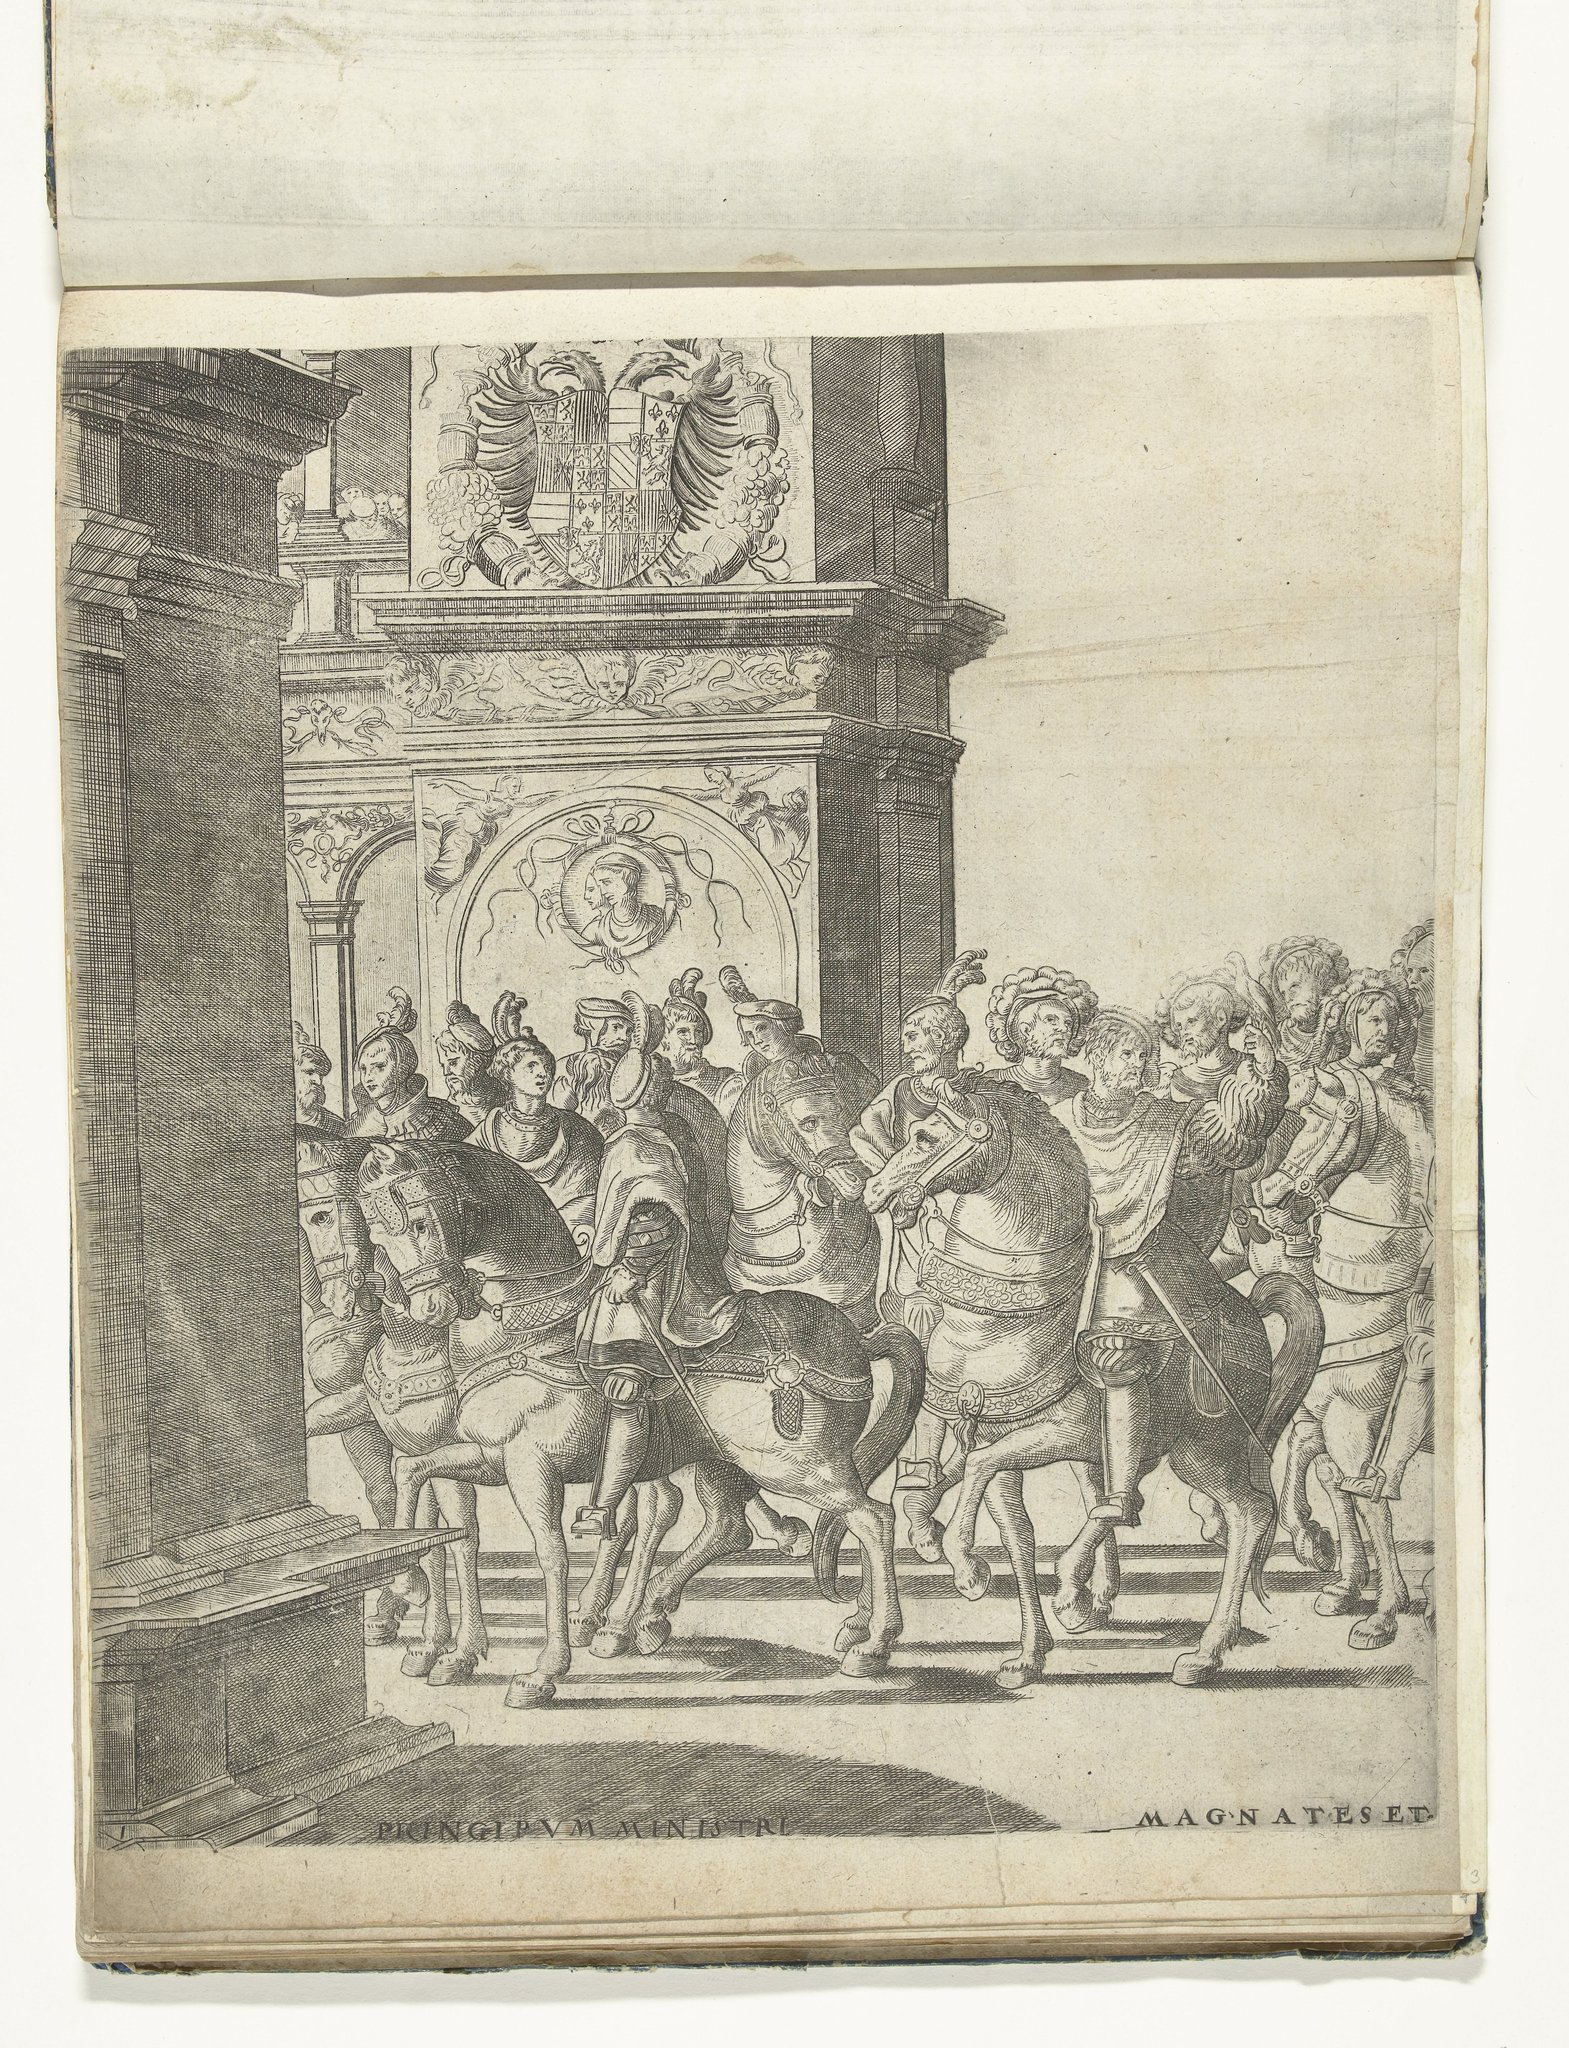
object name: print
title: Optocht van Karel V met de paus te Bologna na zijn kroning to keizer, 1530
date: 1530-1536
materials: paper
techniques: engraving, etching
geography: mechelen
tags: ghent, charles v (holy roman emperor and king of spain), festivities (+ parade, pageant, cavalcade ~ festive activities)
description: Prent in het album waarin zijn ingeplakt de 40 platen die achterelkaar samen het fries vormen van de optocht van Karel V met de paus Clemens VII te Bologna na zijn kroning tot keizer, 24 februari 1530.